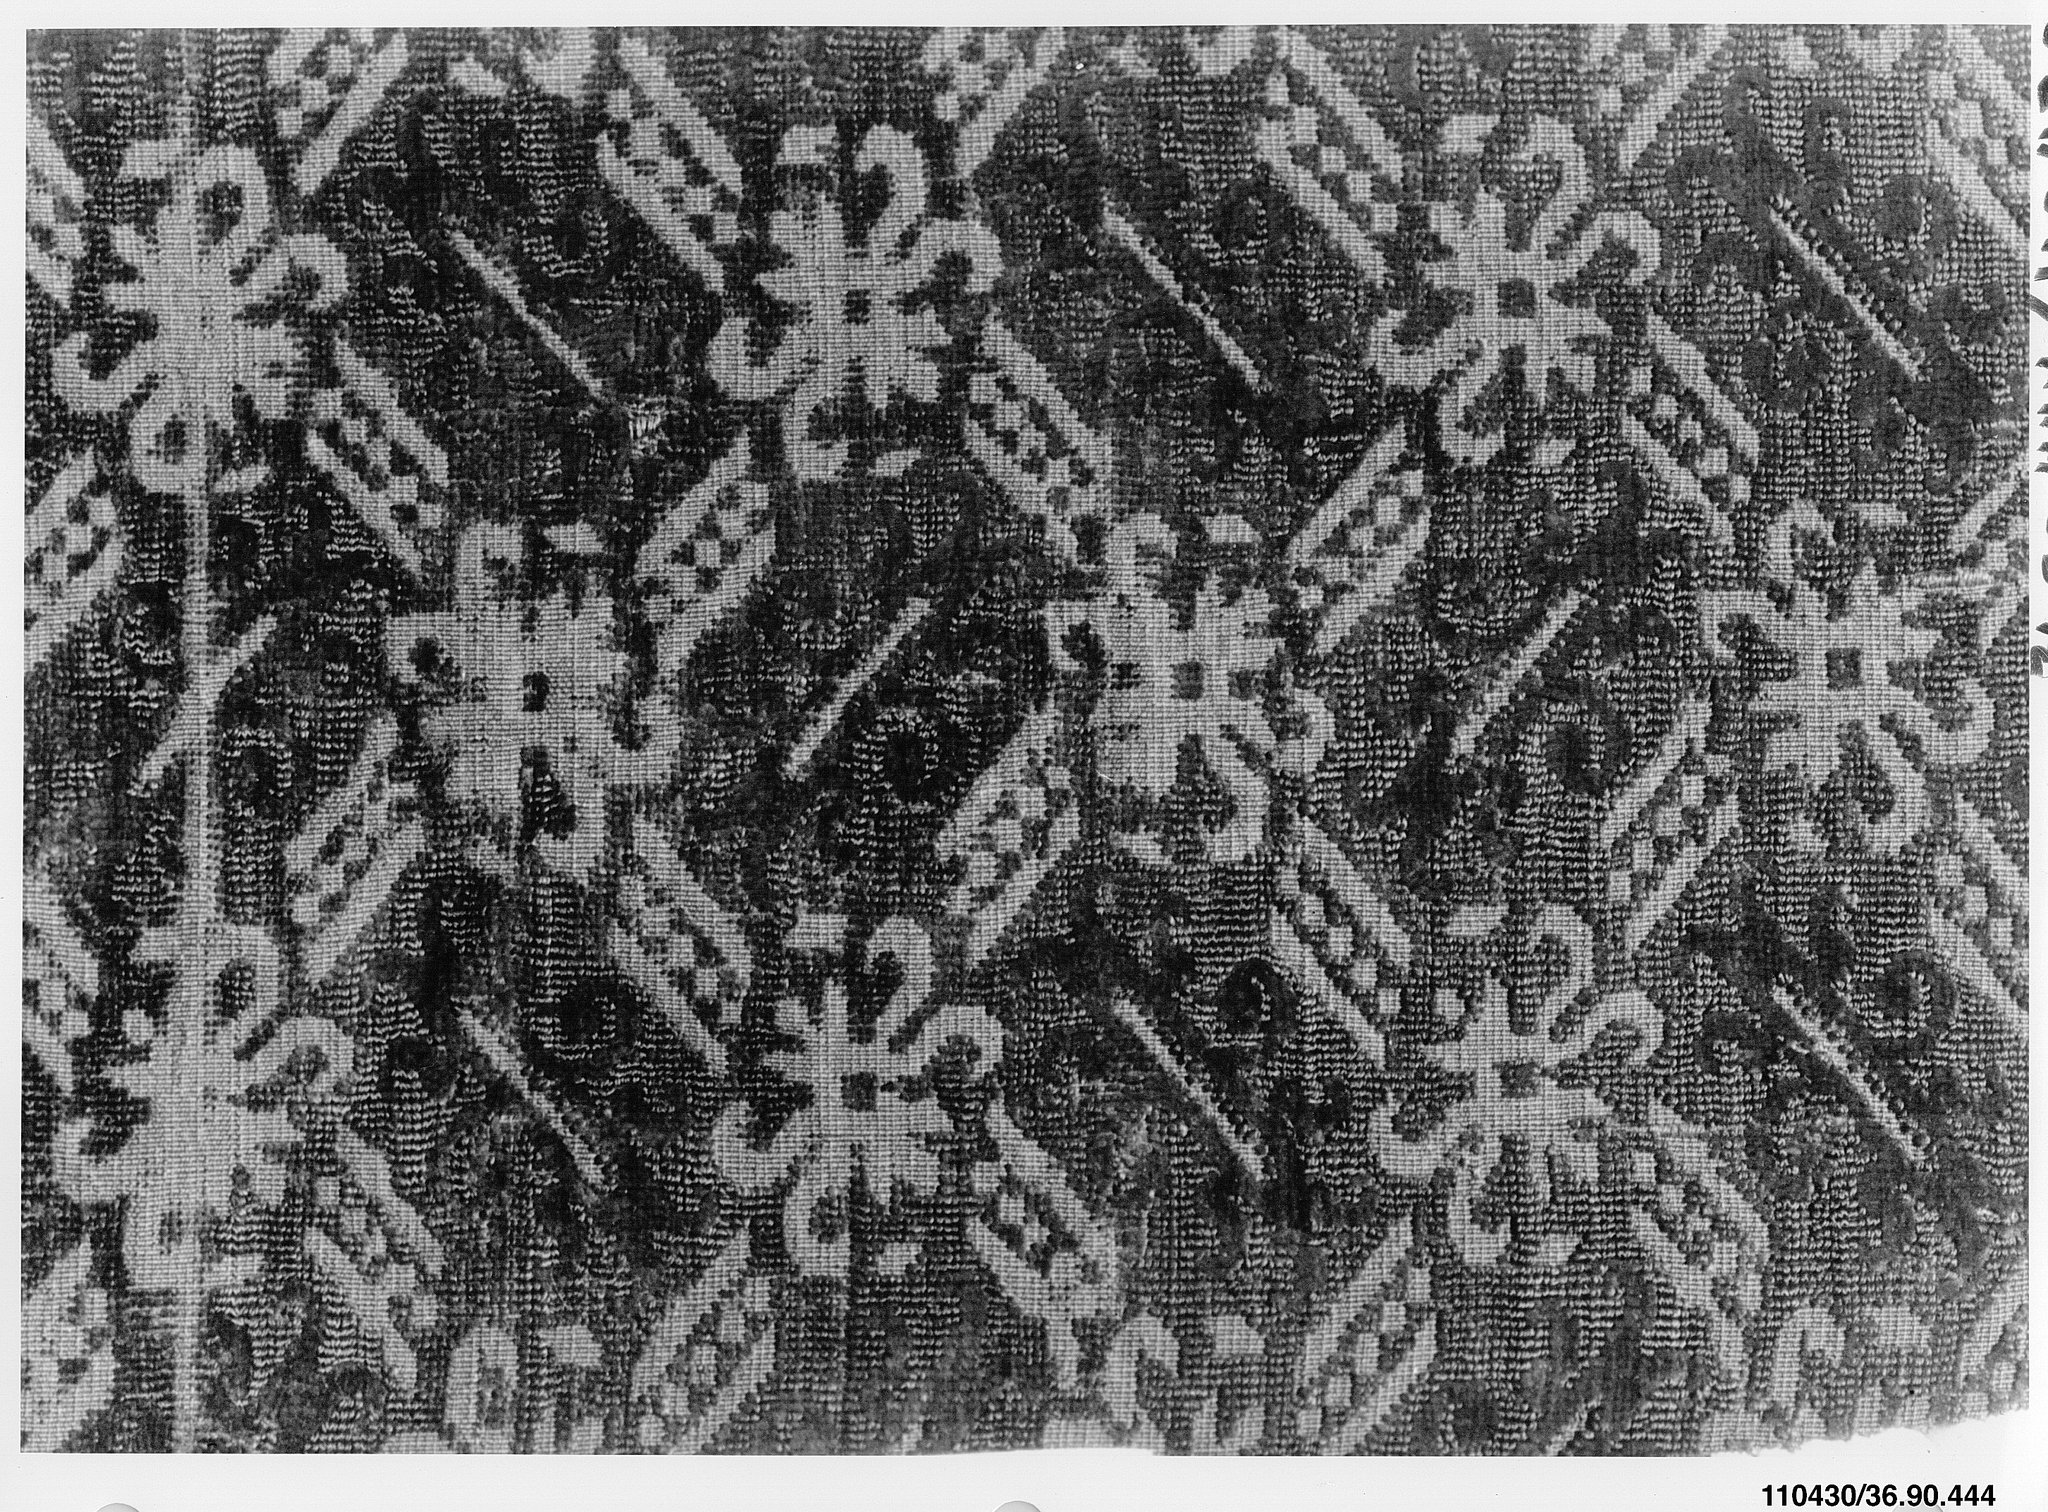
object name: piece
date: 1501-1700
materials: silk